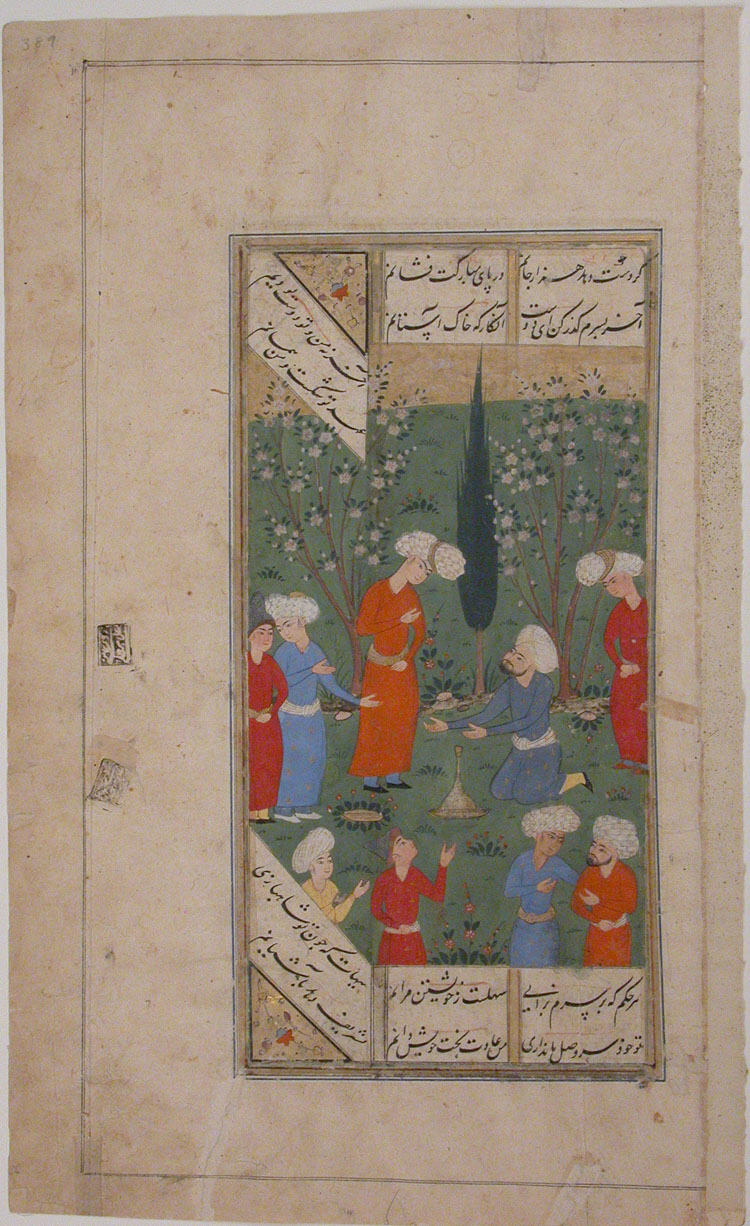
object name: folio from an illustrated manuscript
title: "A Scene of Lovers and their Friends in a Garden", Folio from a Kulliyat (Complete Works) of Sa'di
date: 1801-1900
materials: gold, ink, paper, watercolor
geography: india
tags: gardens,men,lovers,women